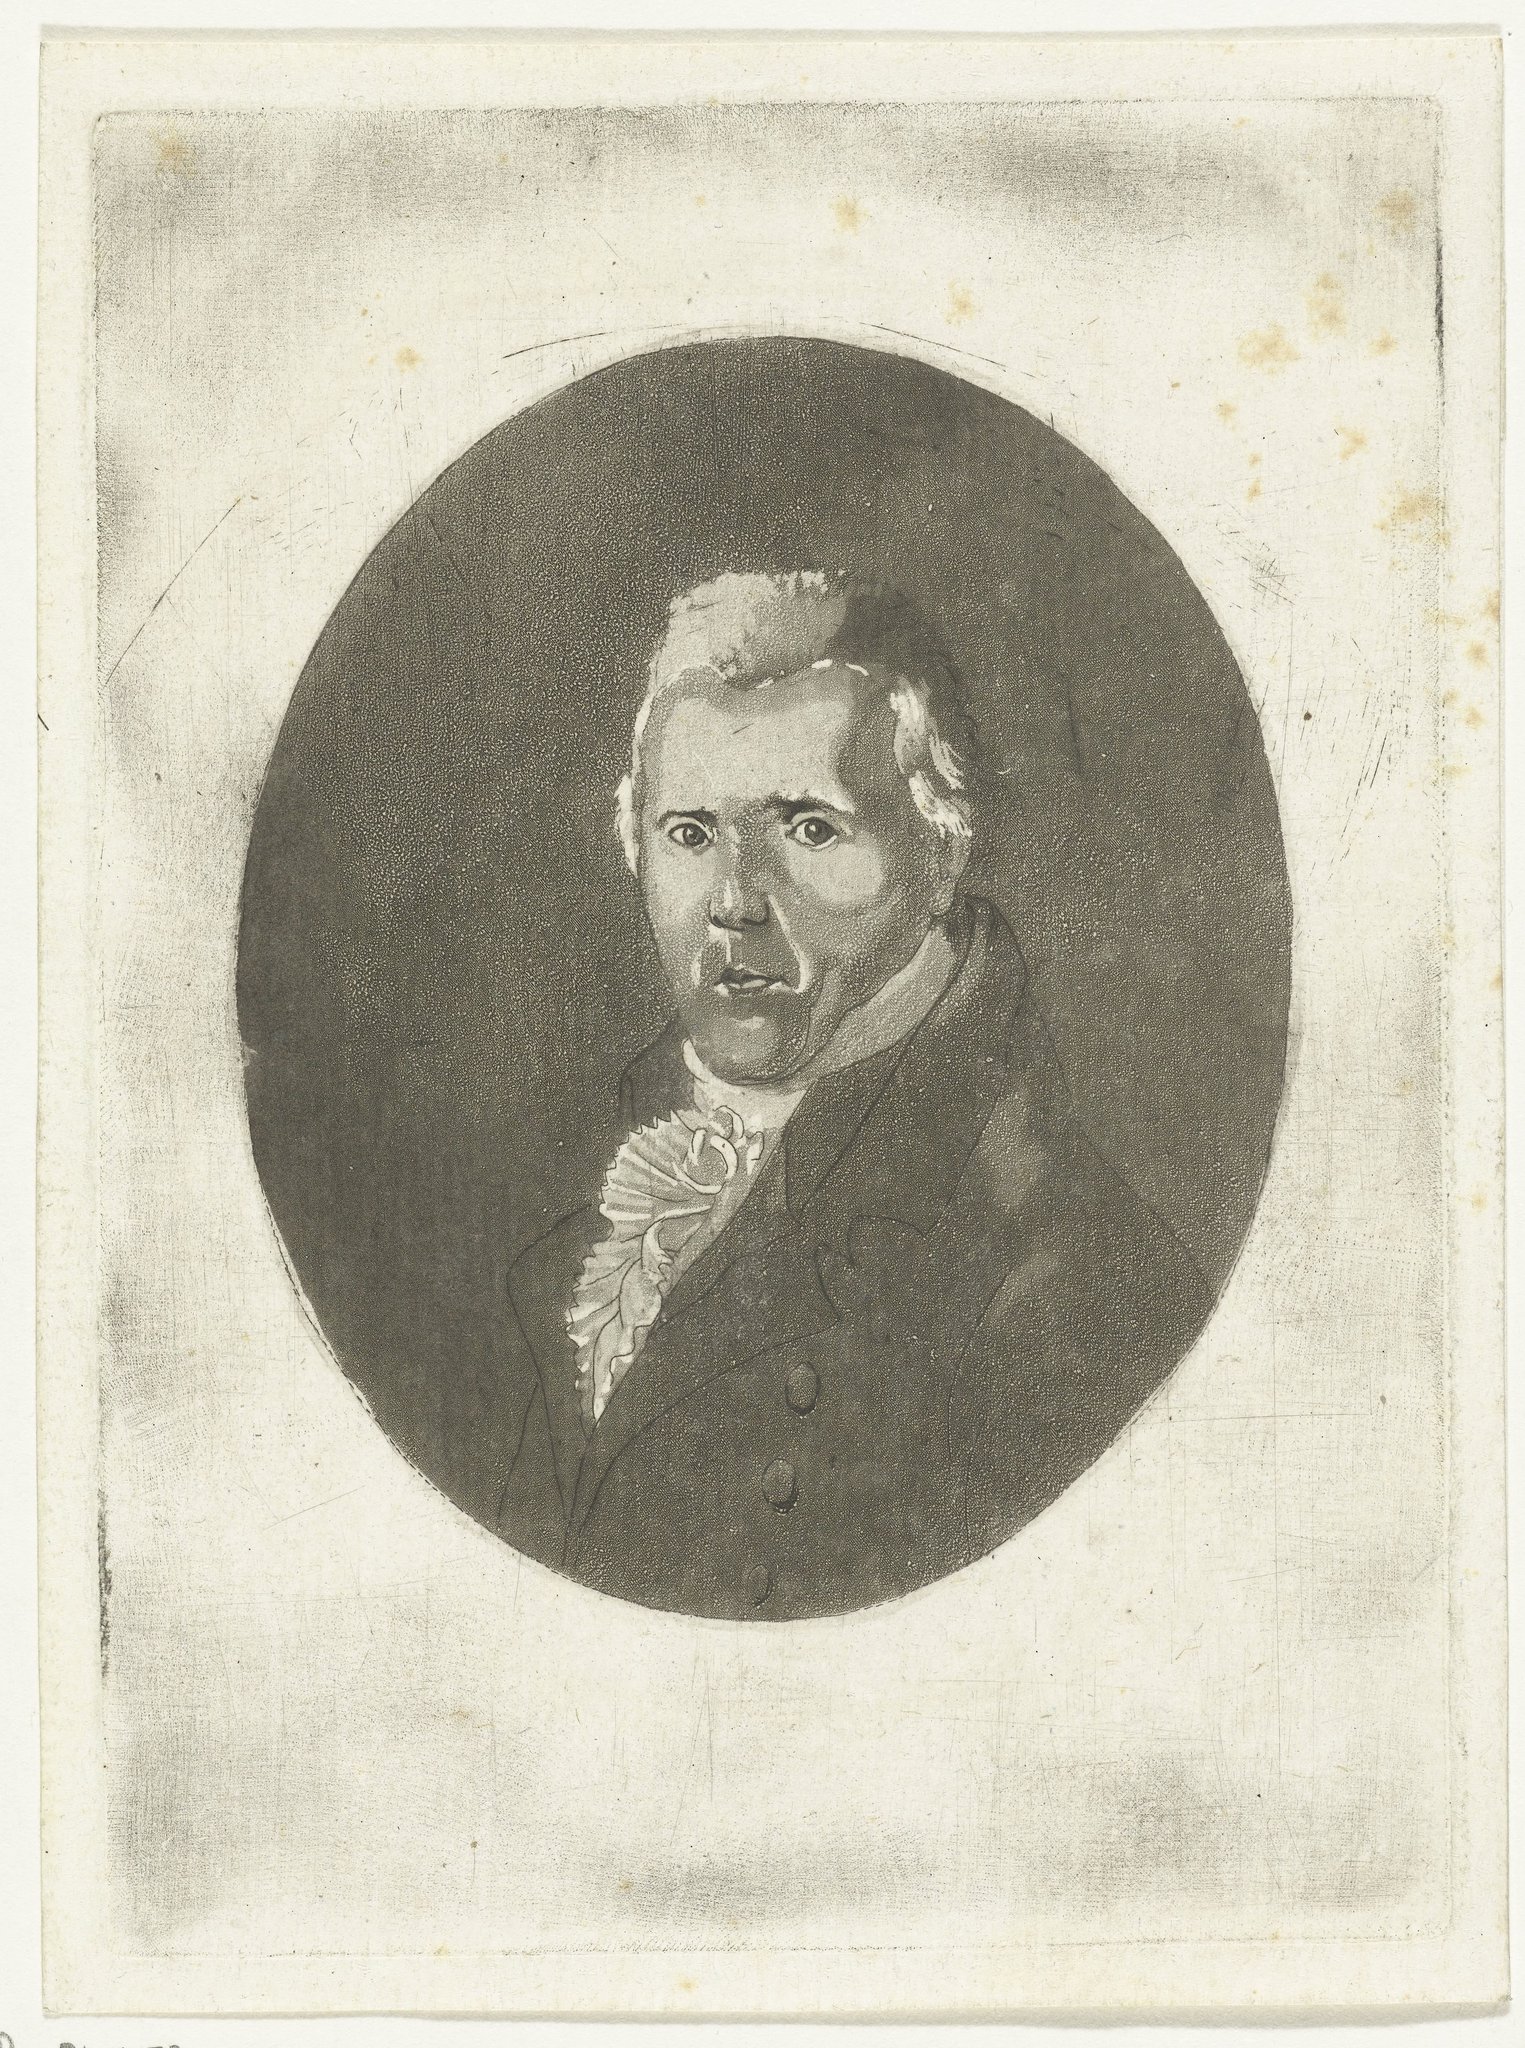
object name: print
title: Portret van professor Jan Konijnenburg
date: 1778-1838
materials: paper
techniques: aquatint, etching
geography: netherlands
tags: jan konijnenburg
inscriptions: collector's mark: Lugt 2228